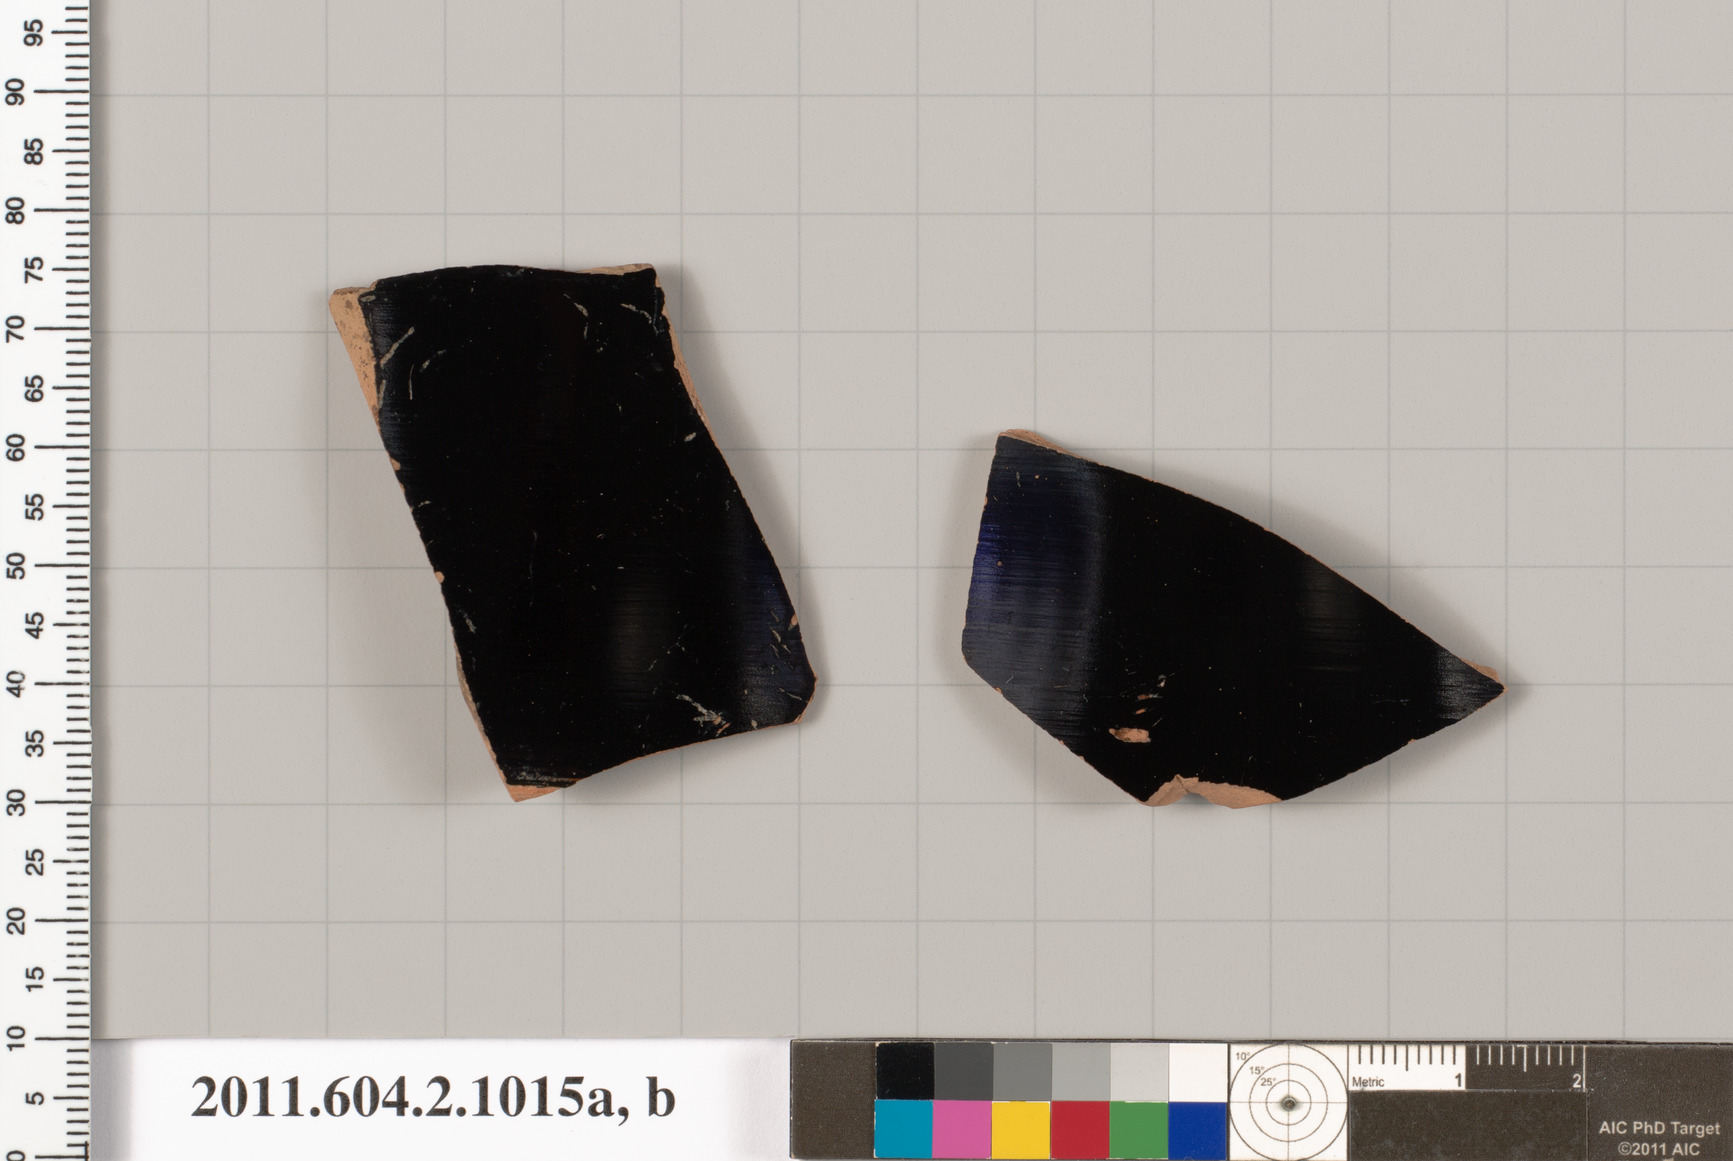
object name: oinochoe fragment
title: Terracotta fragments of oinochoai (jugs)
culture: greek, attic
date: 475-425 BCE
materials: terracotta